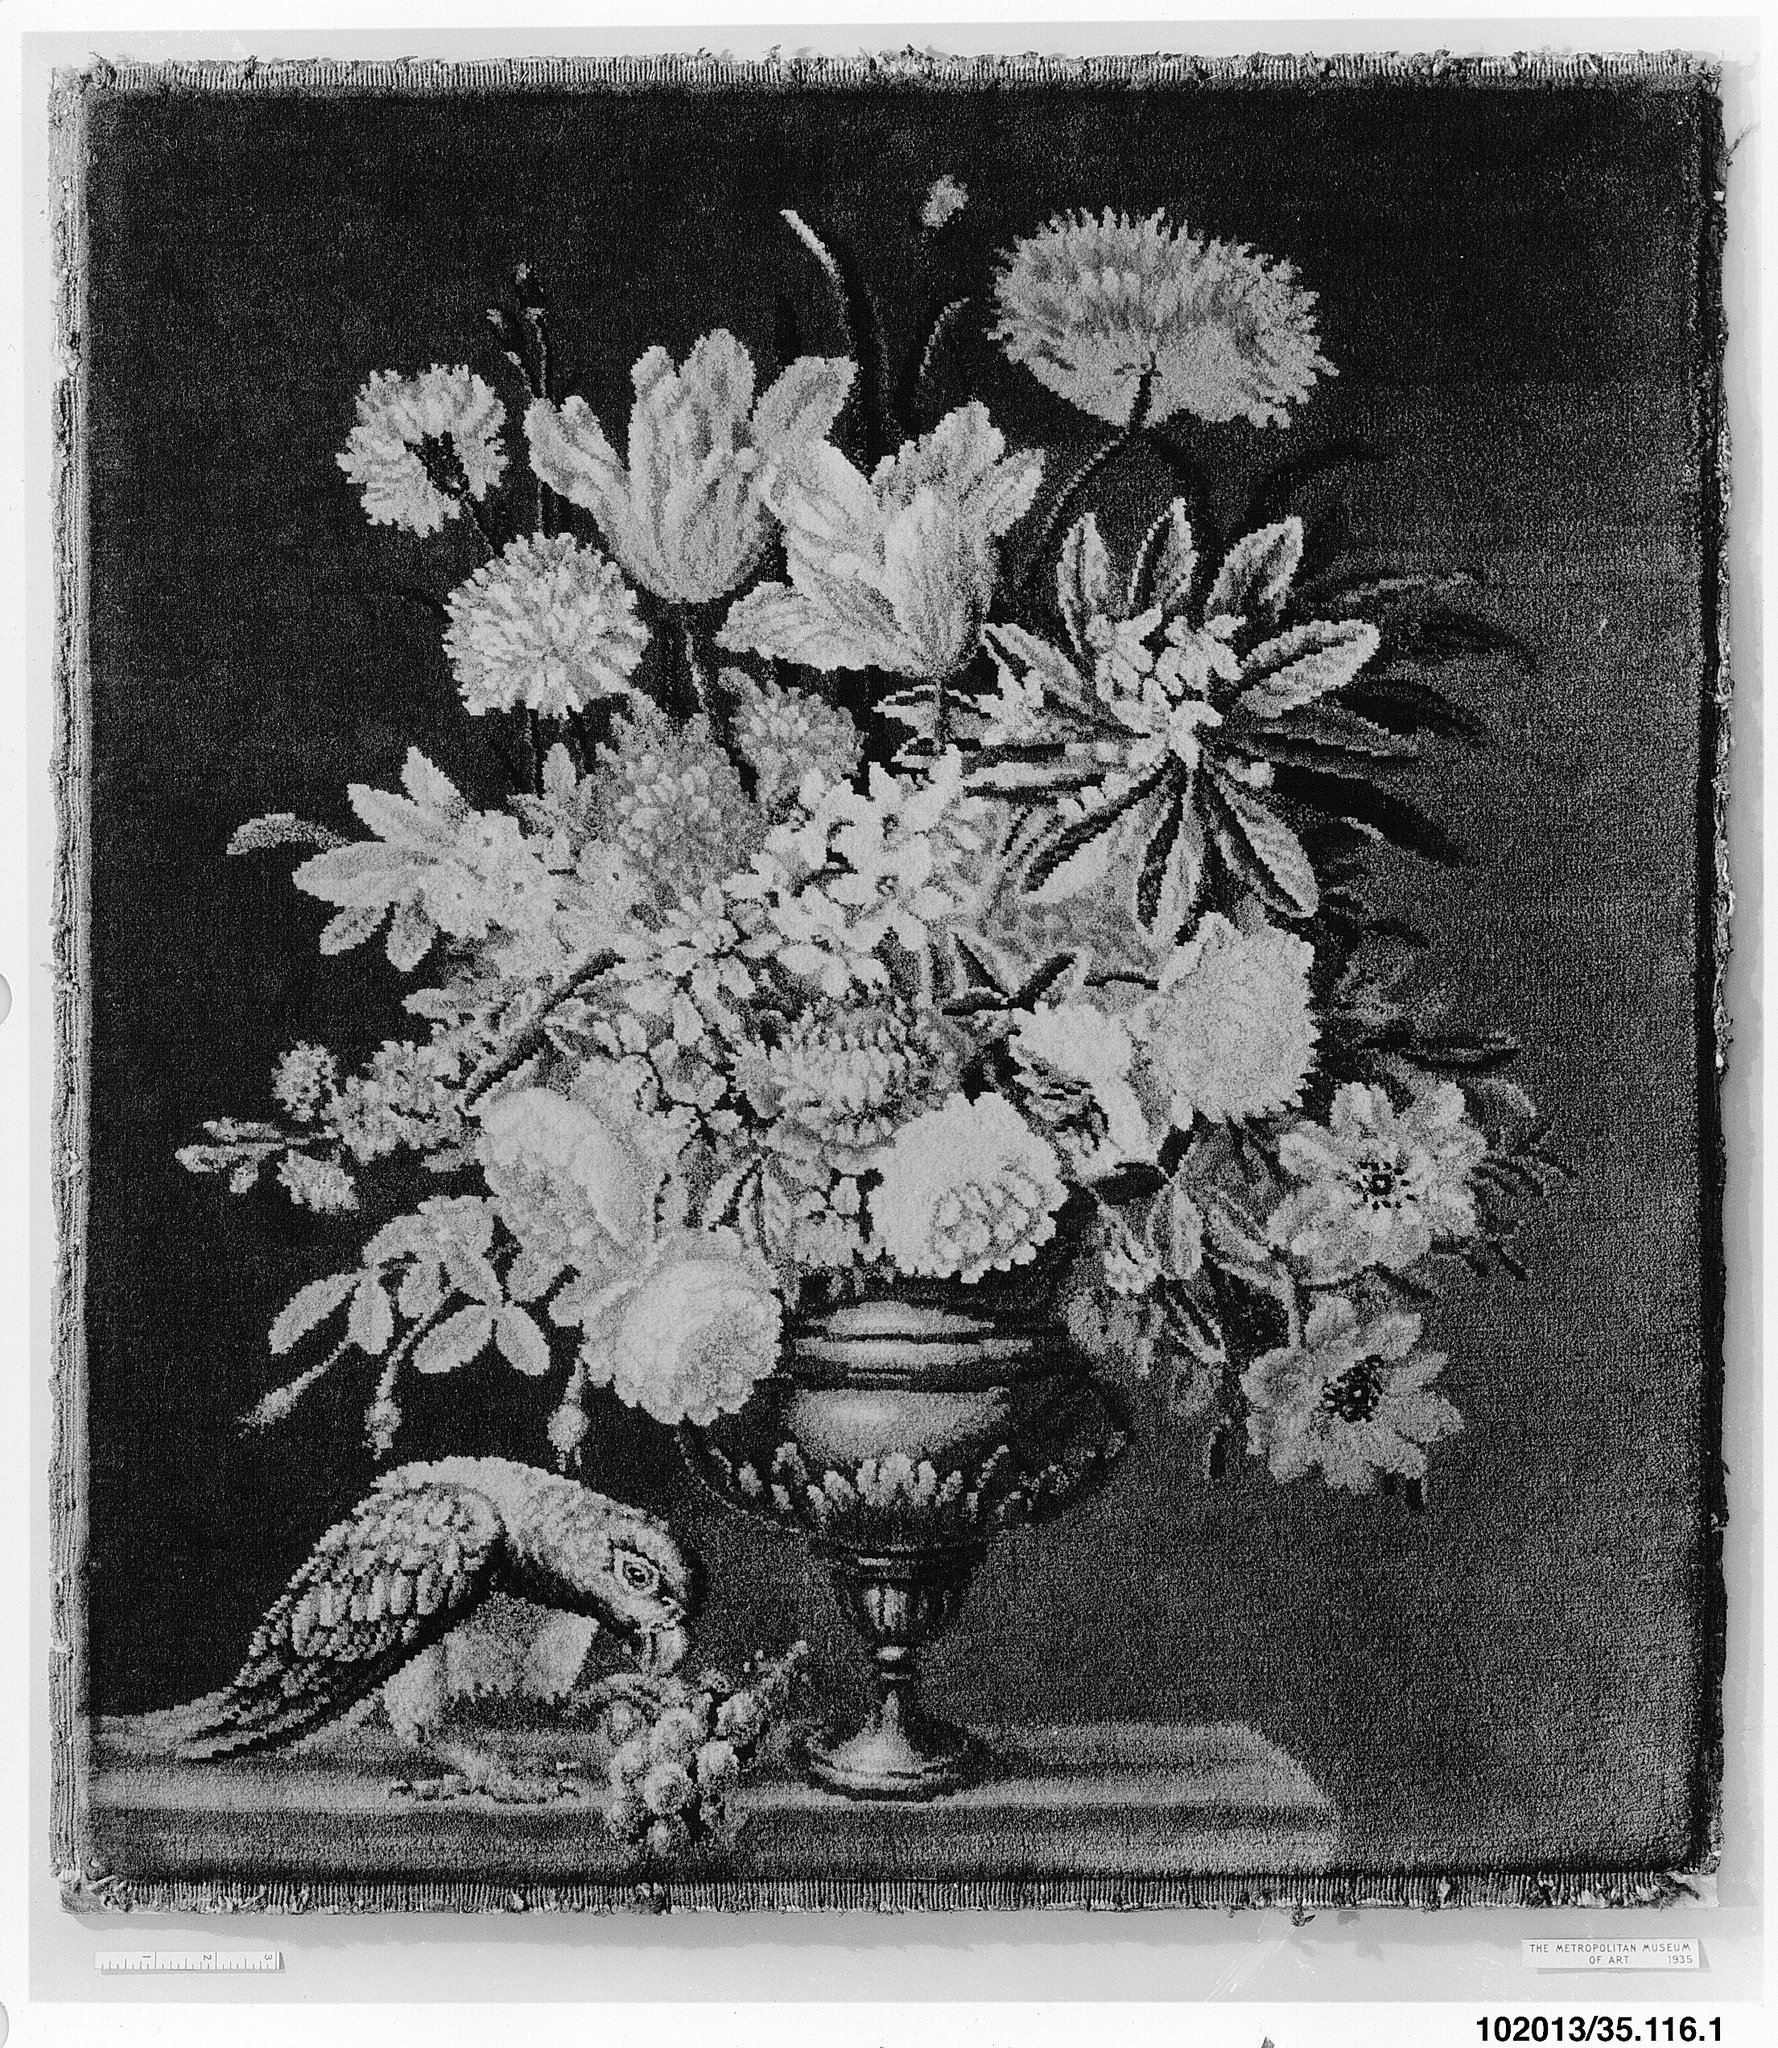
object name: panel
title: Flowers in a golden vase, with a parrot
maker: savonnerie manufactory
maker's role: manufactory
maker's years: 1626-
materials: wool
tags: parrots,flowers